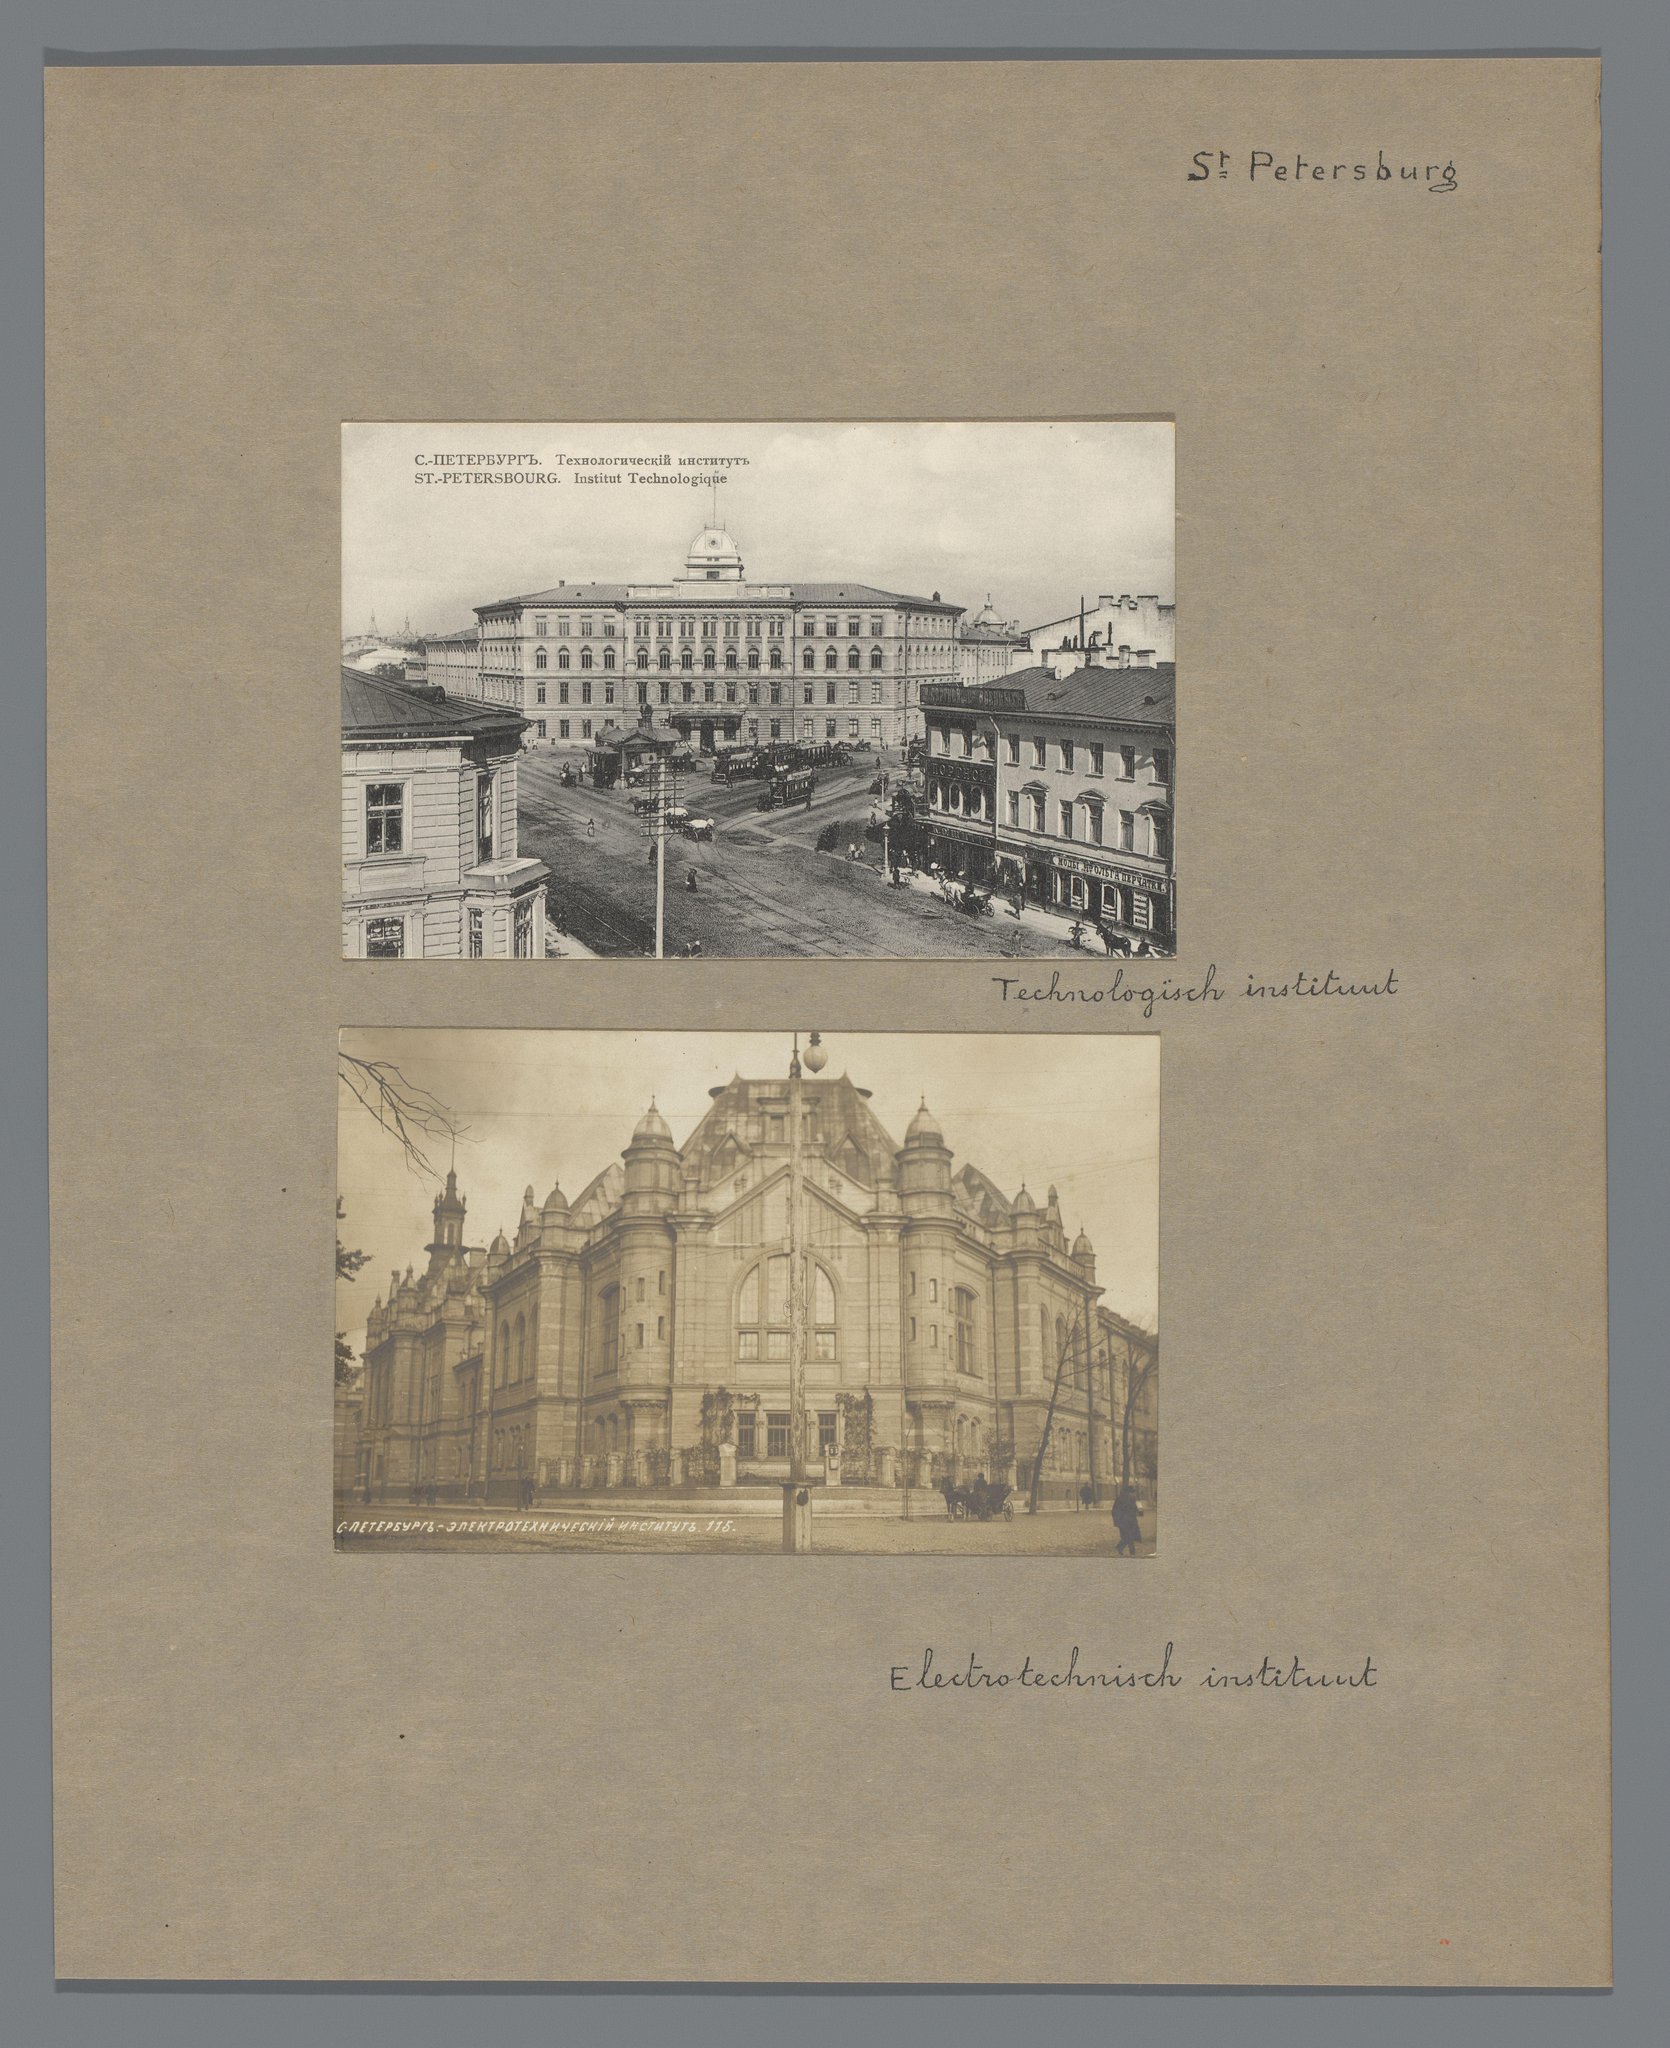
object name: photograph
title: St. Petersburg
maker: Anonymous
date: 1860-1925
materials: photographic support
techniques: photograph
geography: russia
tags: sint-petersburg